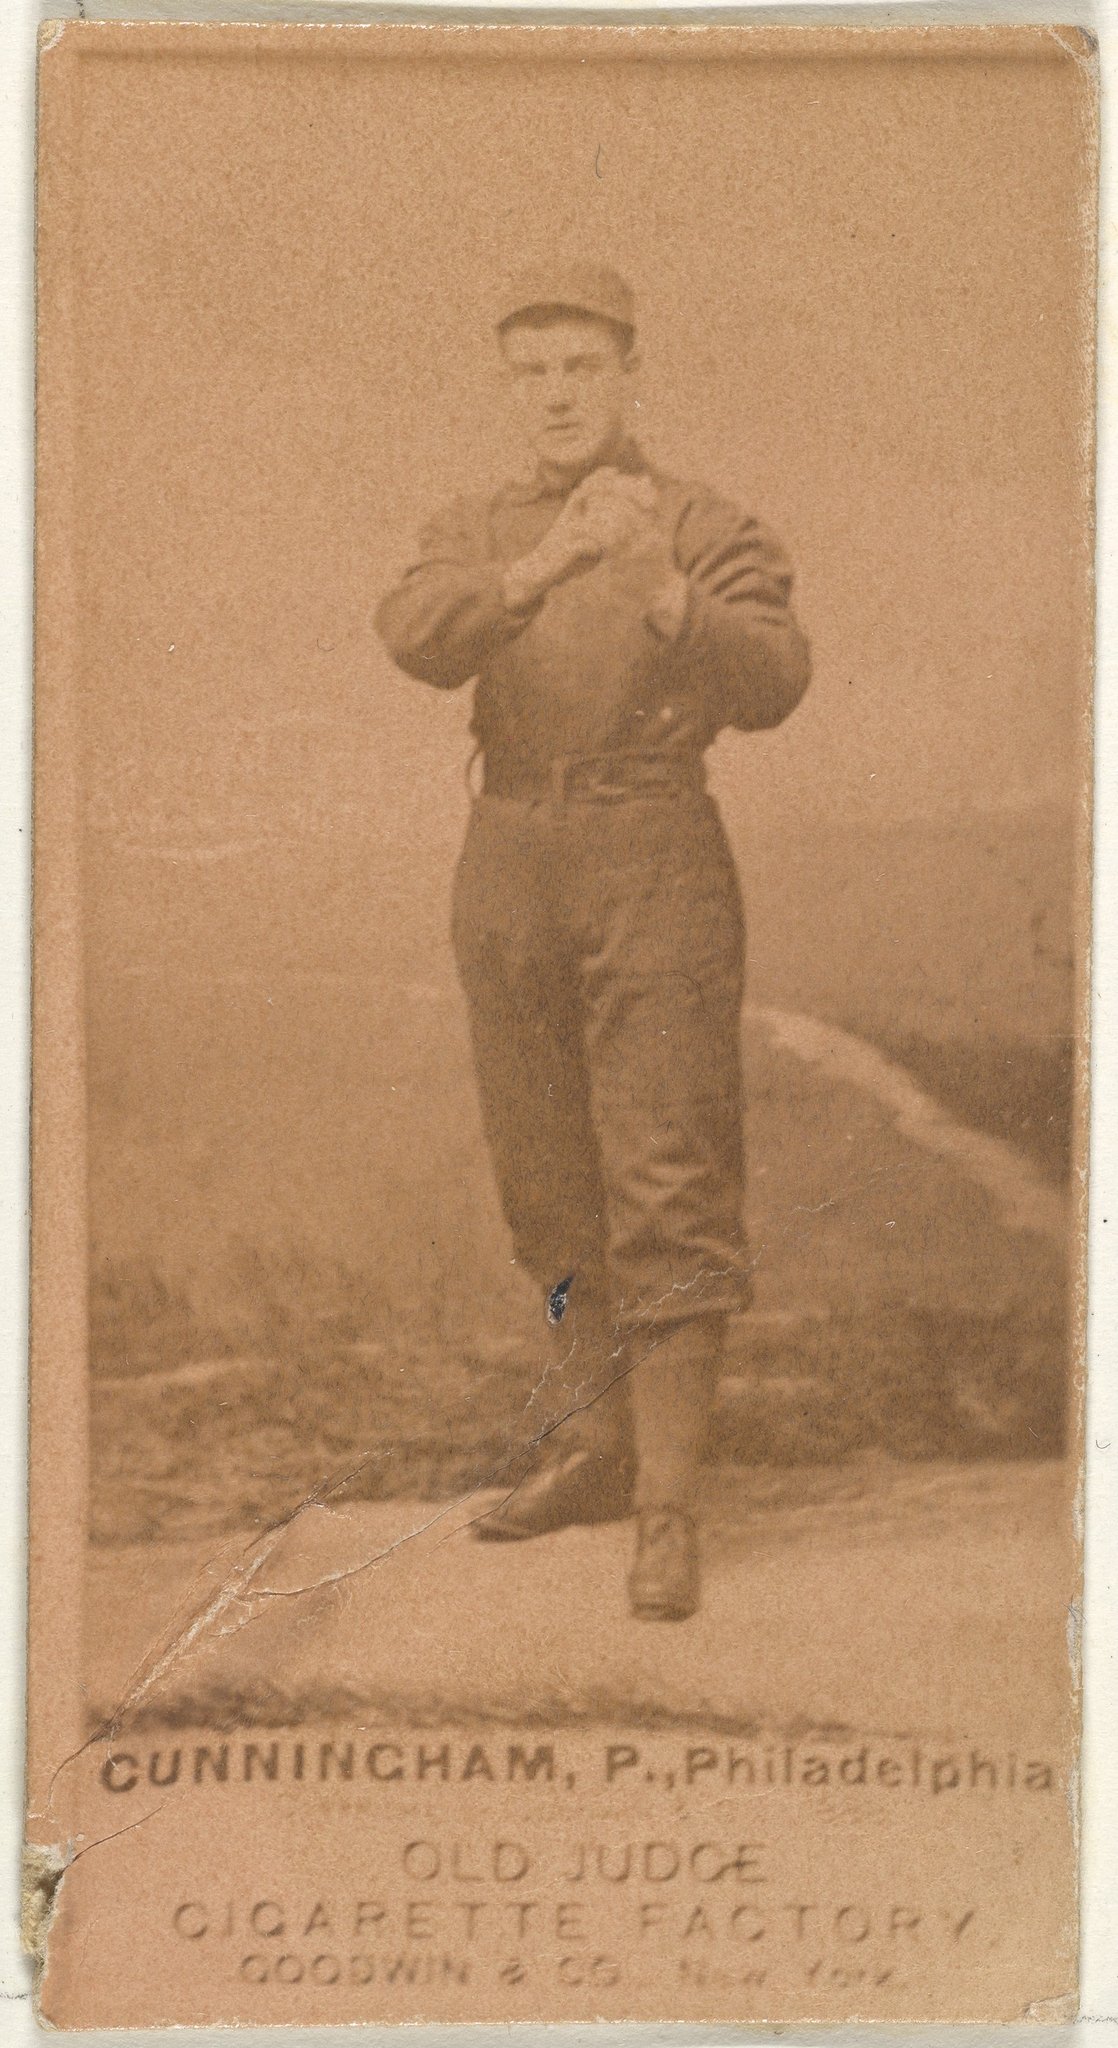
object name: baseball card, photograph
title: Cunningham, Pitcher, Philadelphia, from the Old Judge series (N172) for Old Judge Cigarettes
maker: goodwin & company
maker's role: publisher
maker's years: 1850-1950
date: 1888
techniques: albumen silver print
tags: men,portraits,baseball,athletes